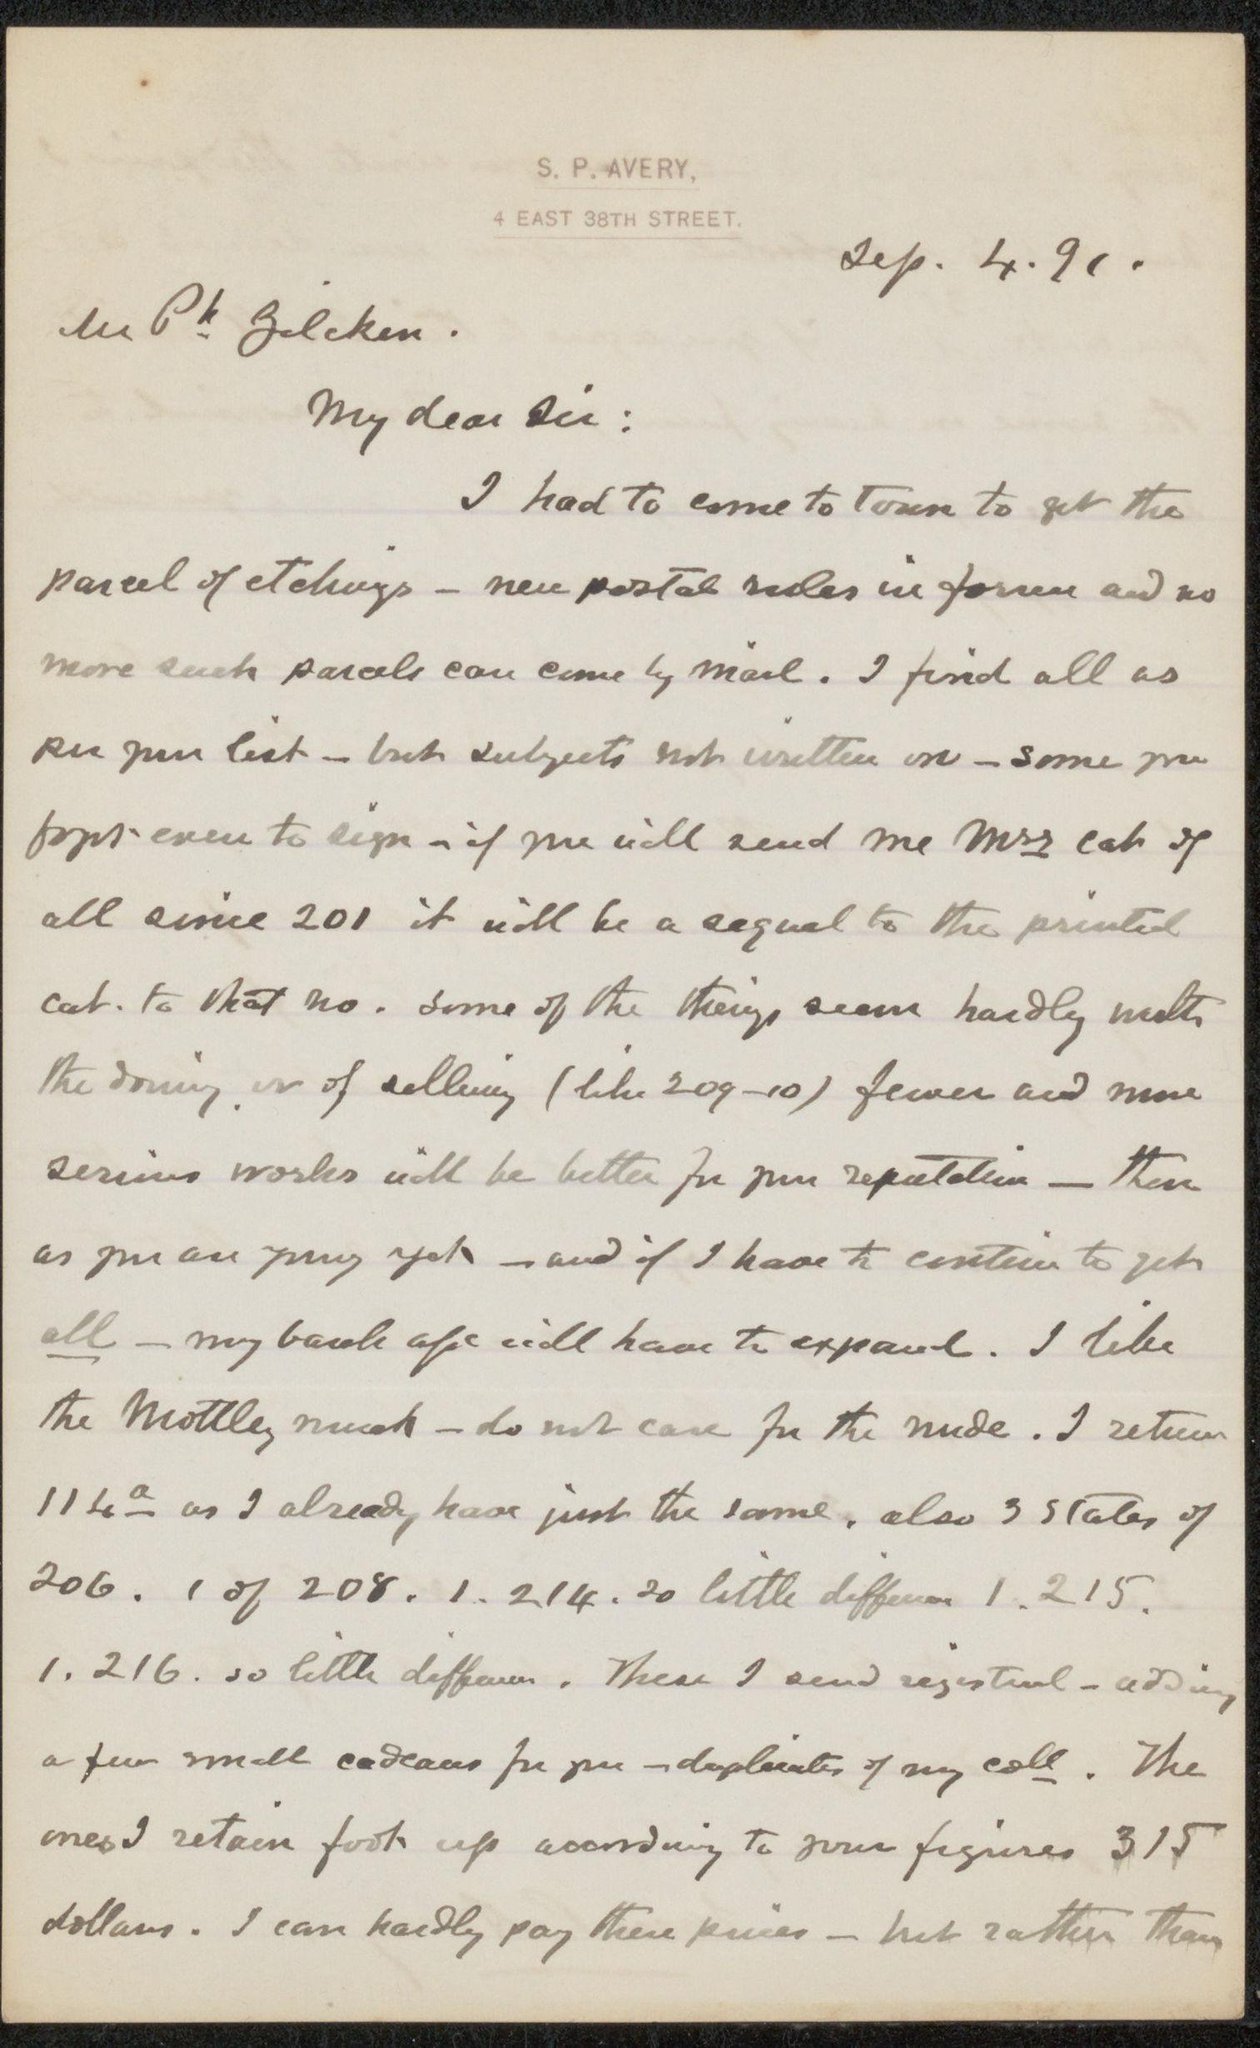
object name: letter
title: Brief aan Philip Zilcken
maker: samuel putnam avery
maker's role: verzamelaar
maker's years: 1822-1904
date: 1891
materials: ink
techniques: pen, printing, writing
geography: new york city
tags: the hague, painter, print maker, draughtsman, jozef israëls, philip zilcken, art trade, art shop, sending and receiving postal matter, the graphic arts, art collecting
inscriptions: collector's mark: ‘RPK’